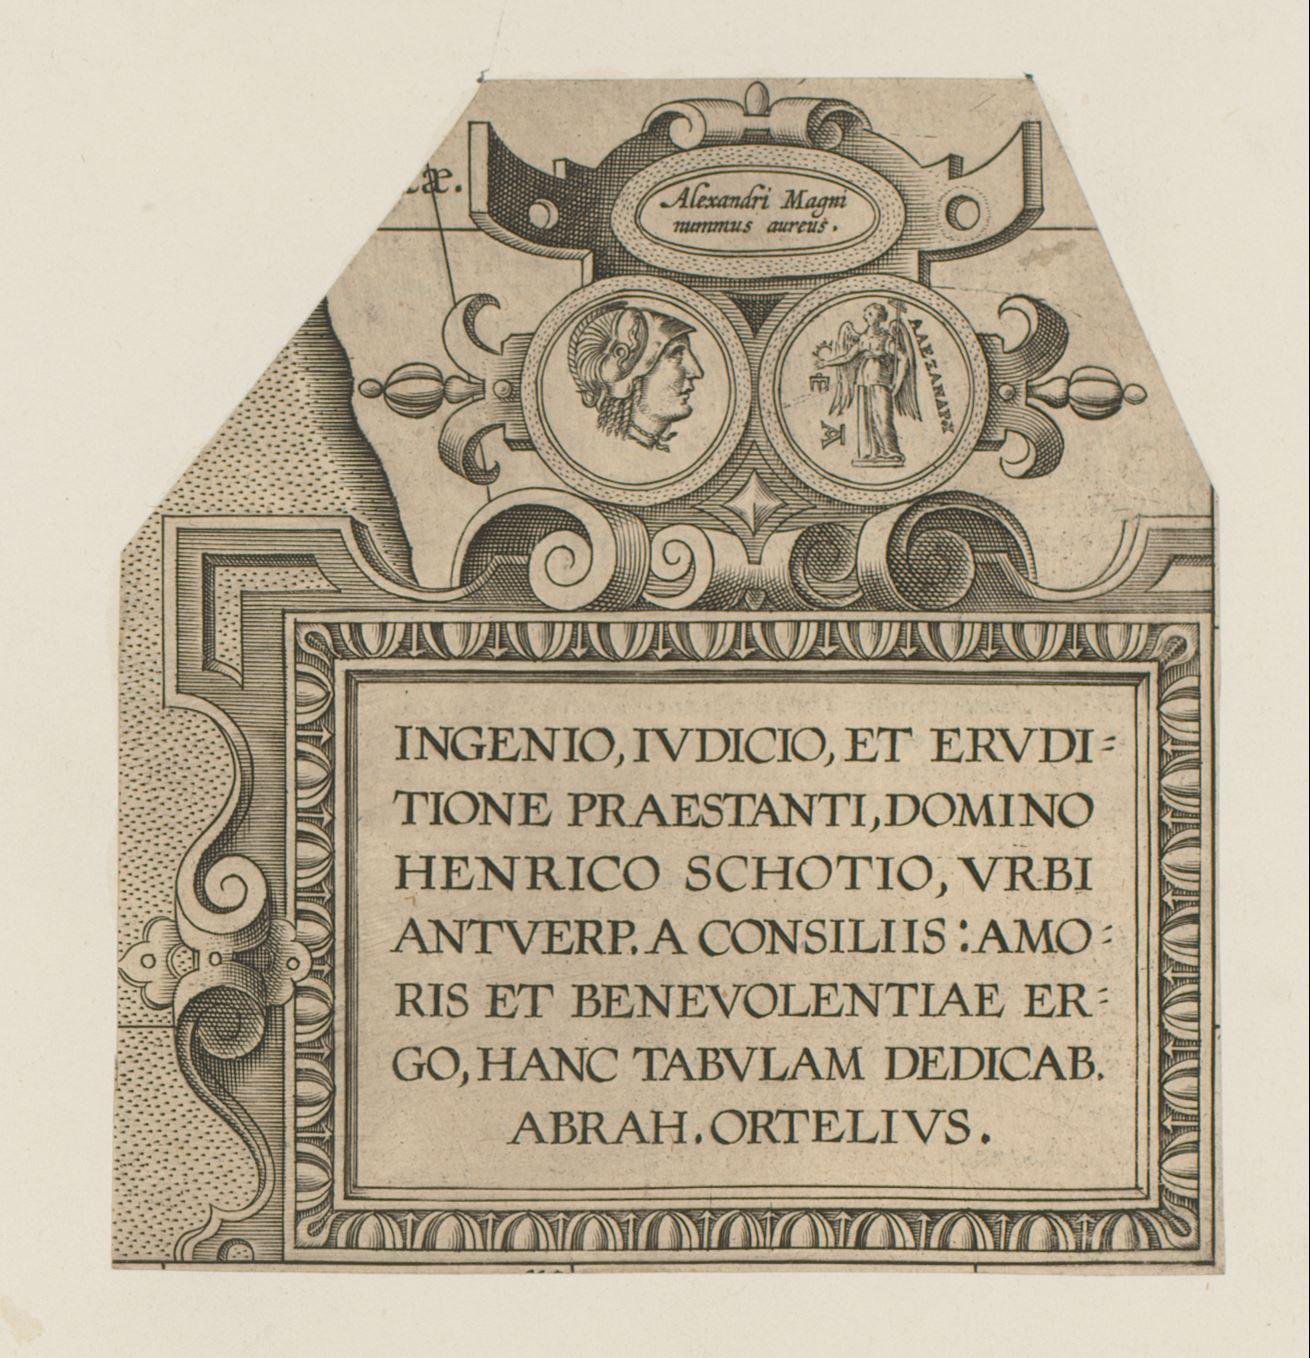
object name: album leaf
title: Cartouche van een kaart van de expeditie van Alexander de Grote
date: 1595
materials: paper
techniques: engraving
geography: antwerp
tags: 'victoria'; 'vittoria', 'vittoria navale', 'vittoria degl'antichi' (ripa), ornament ~ cartouche, coin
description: Rechthoekige cartouche van een kaart van de expeditie van Alexander de Grote. Bovenop aan afbeelding van de voor- en achterzijde van een munt met links het portret van Alexander en rechts Victoria. De prent maakt deel uit van een album.